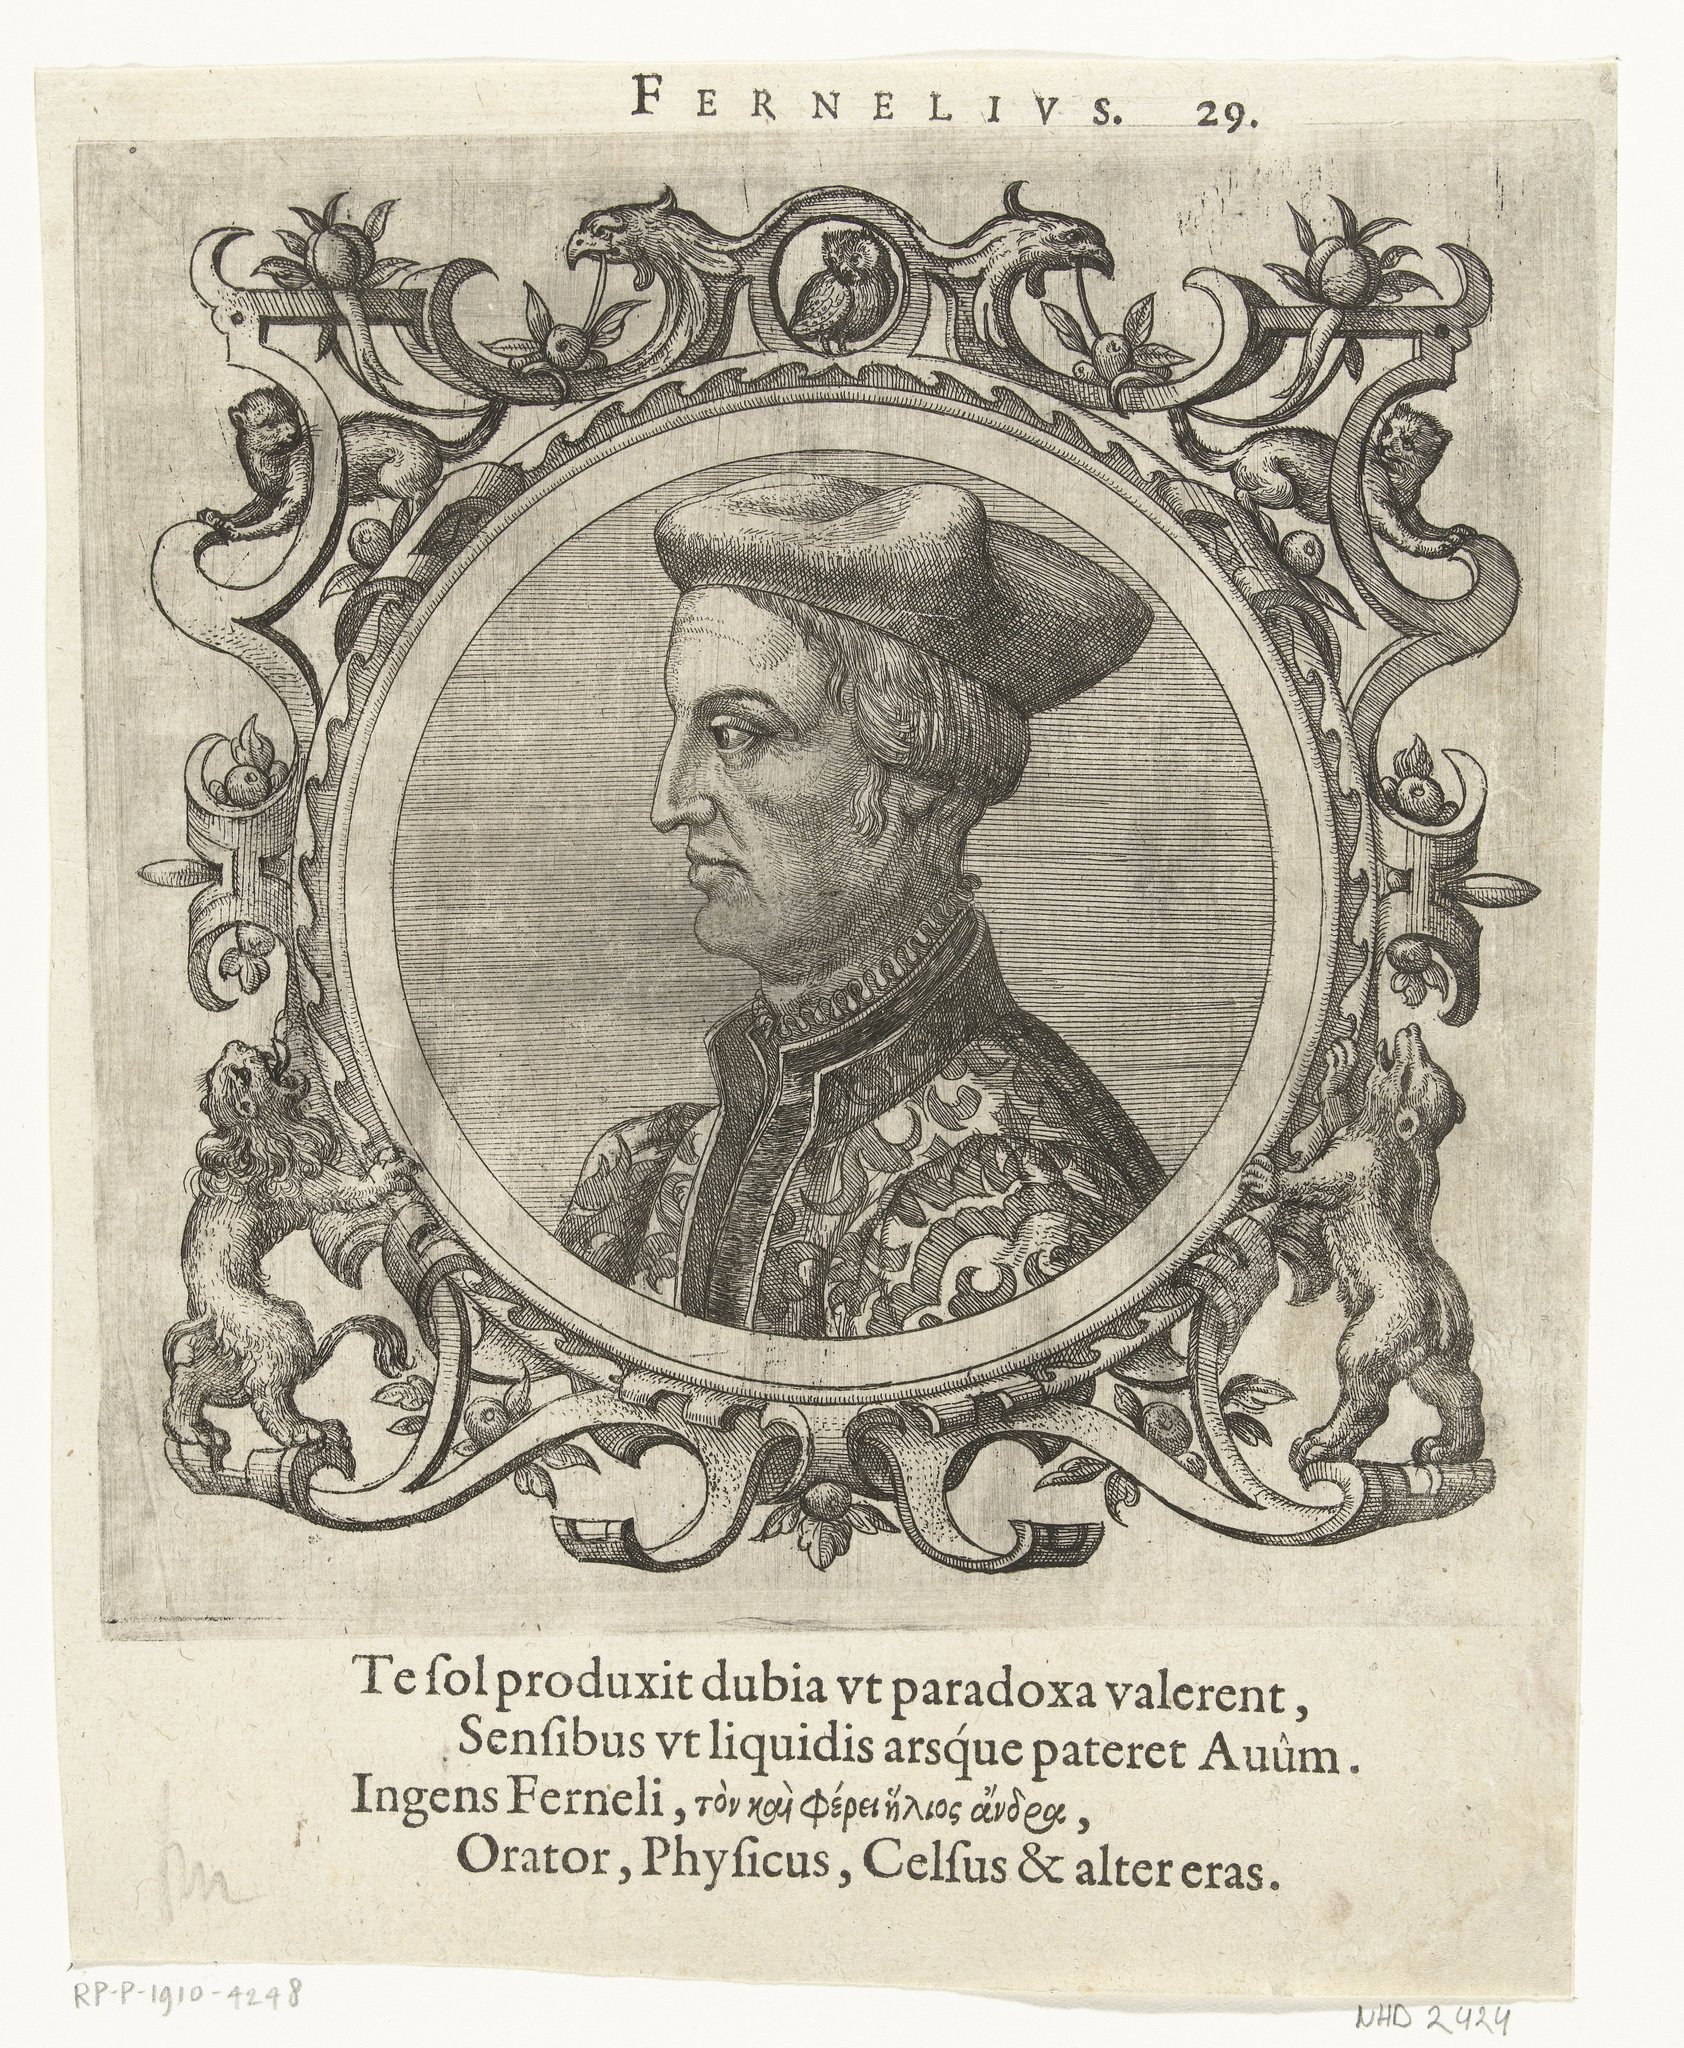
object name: book illustration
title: Portret van Johannes Fernelius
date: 1574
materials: paper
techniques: etching, letterpress printing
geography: antwerp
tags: cat, beasts of prey, predatory animals: bear, ornament ~ cartouche, owls, beasts of prey, predatory animals: lion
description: Een portret met een ronde lijst van Johannes Fernelius (Jean Francois Fernel), de hofarts van Frans I. Buste naar links. De cartouche van het portret toont een uil midden boven, met links en rechts twee katten. Linksonder een staande leeuw en rechtsonder een staande beer. Onder de cartouche is een onderschrift van vier regels in het Latijn. Boven de cartouche de naam van de geportretteerde persoon.